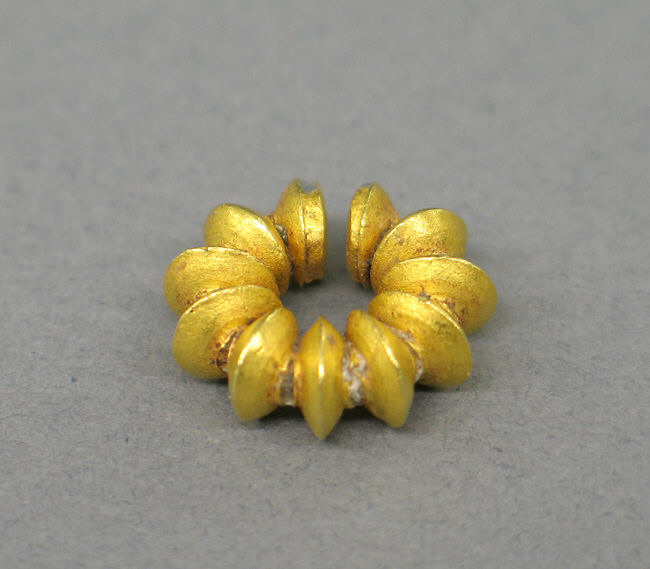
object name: ear clip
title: Ear Clip Composed of Fused Discs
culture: indonesian, javanese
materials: gold